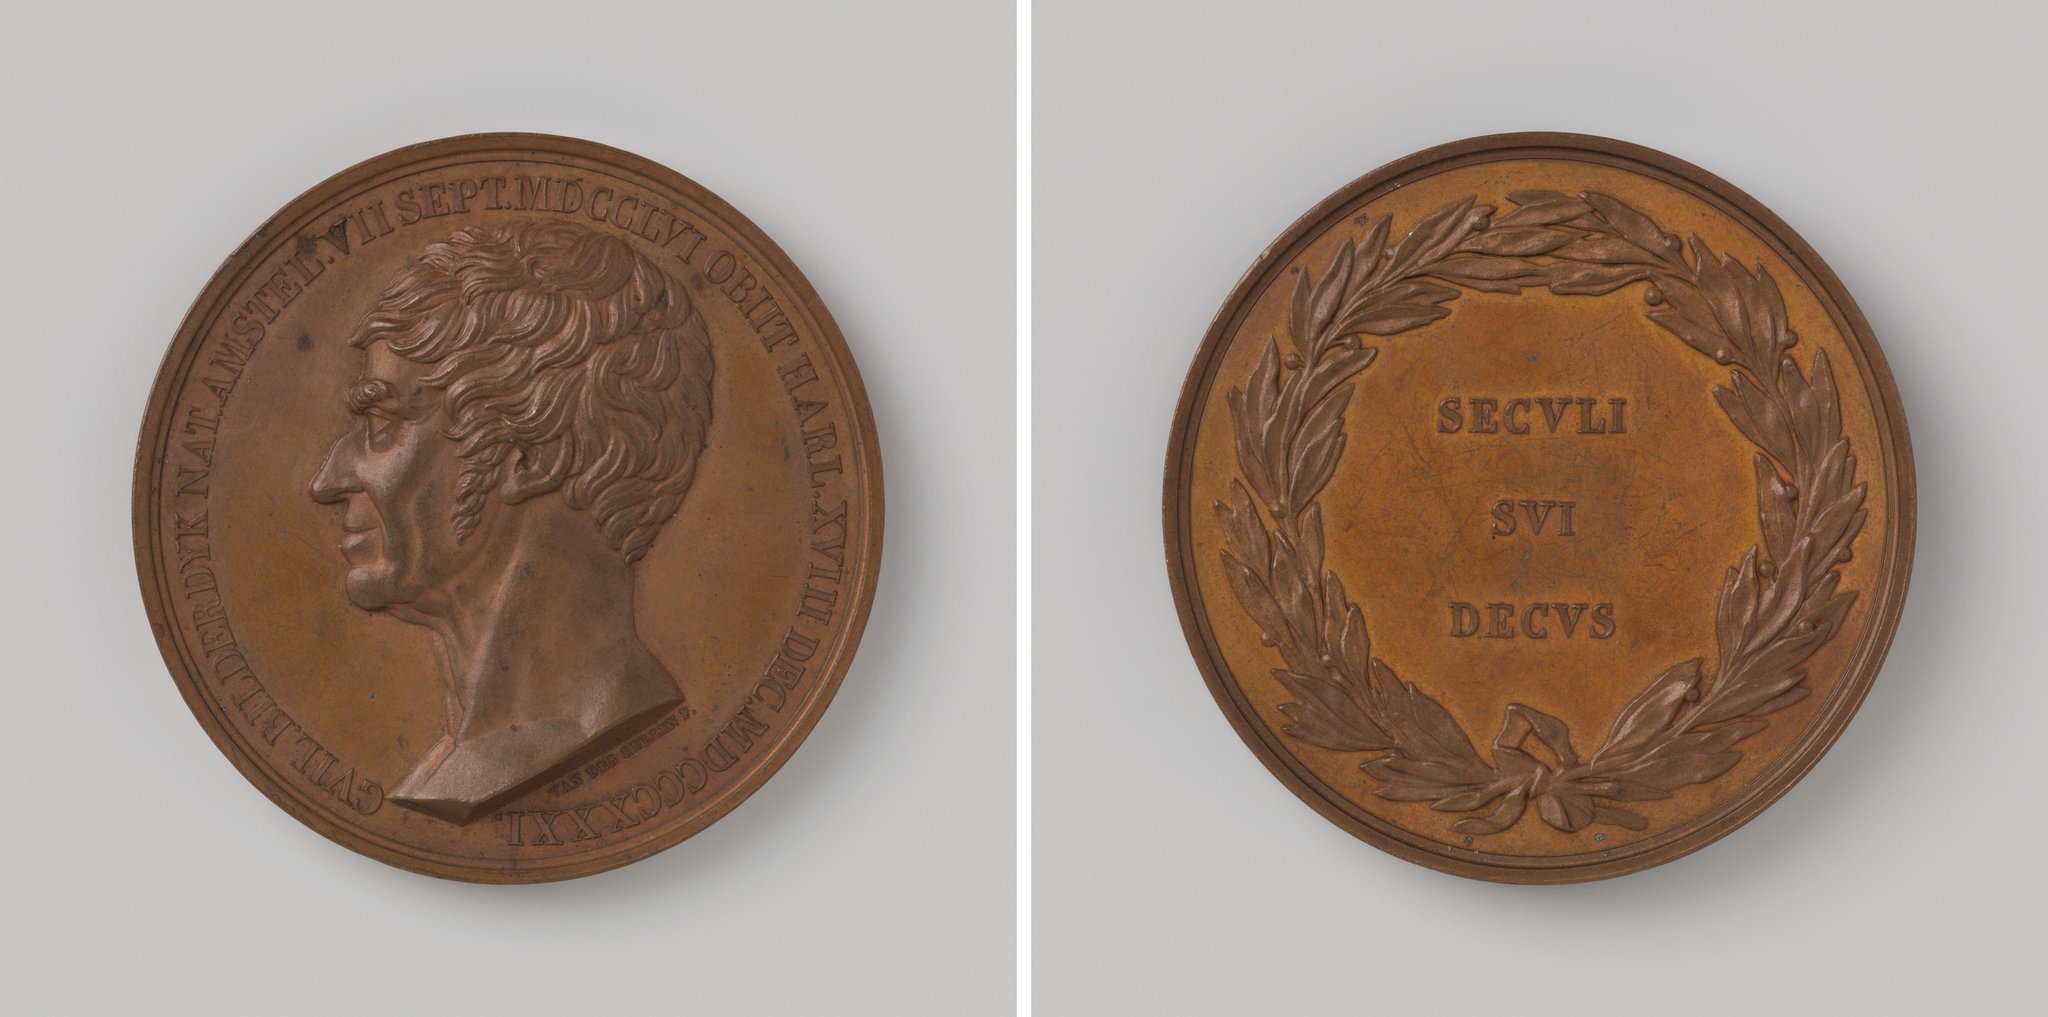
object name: history medal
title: Overlijden van Willem Bilderdijk 1831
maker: david van der kellen (1804-1879)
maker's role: die cutter, draughtsman, print maker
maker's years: 1804-1879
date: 1831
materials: bronze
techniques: striking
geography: utrecht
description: Bronzen penning, op de voorzijde het portret van Bilderdijk naar links met omschrift, op de keerzijde drie regels tekst binnen samengestrikte lauwertakken.